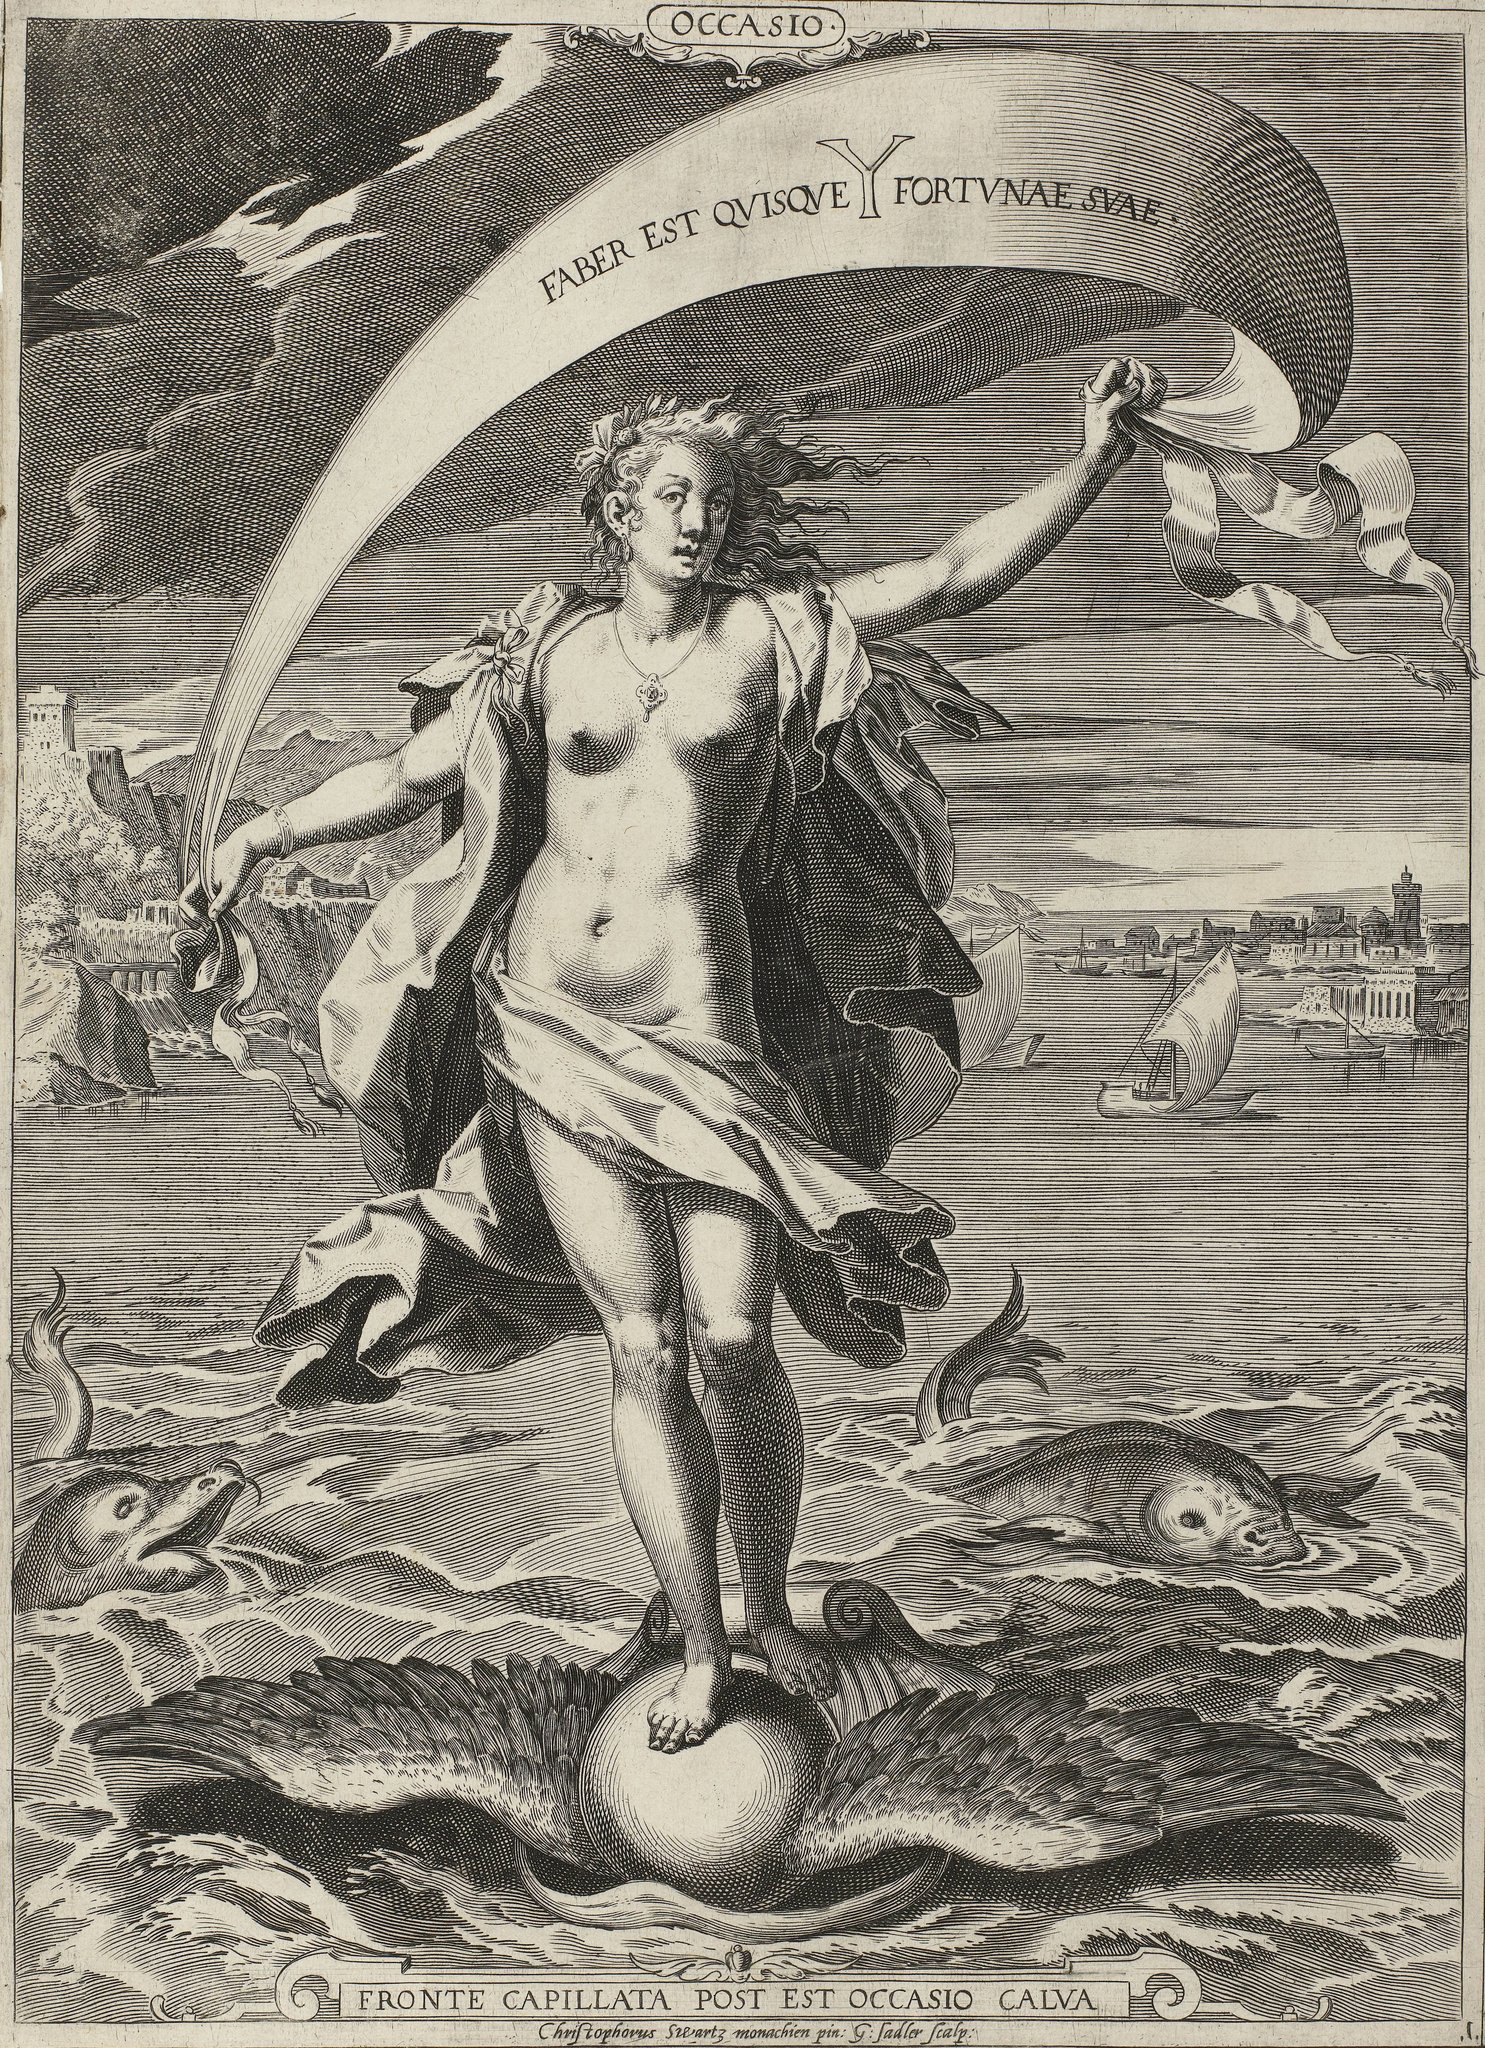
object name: print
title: Occasio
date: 1580-1600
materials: paper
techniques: engraving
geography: vienna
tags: 'occasio', 'kairos'; 'occasione' (ripa)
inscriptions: collector's mark: Lugt 240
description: De personificatie Gelegenheid (Occasio) staat op een gevleugelde bol die op een schelp in een haven ligt . Met het zeil in haar handen vangt ze de wind en vaart ze over het water.